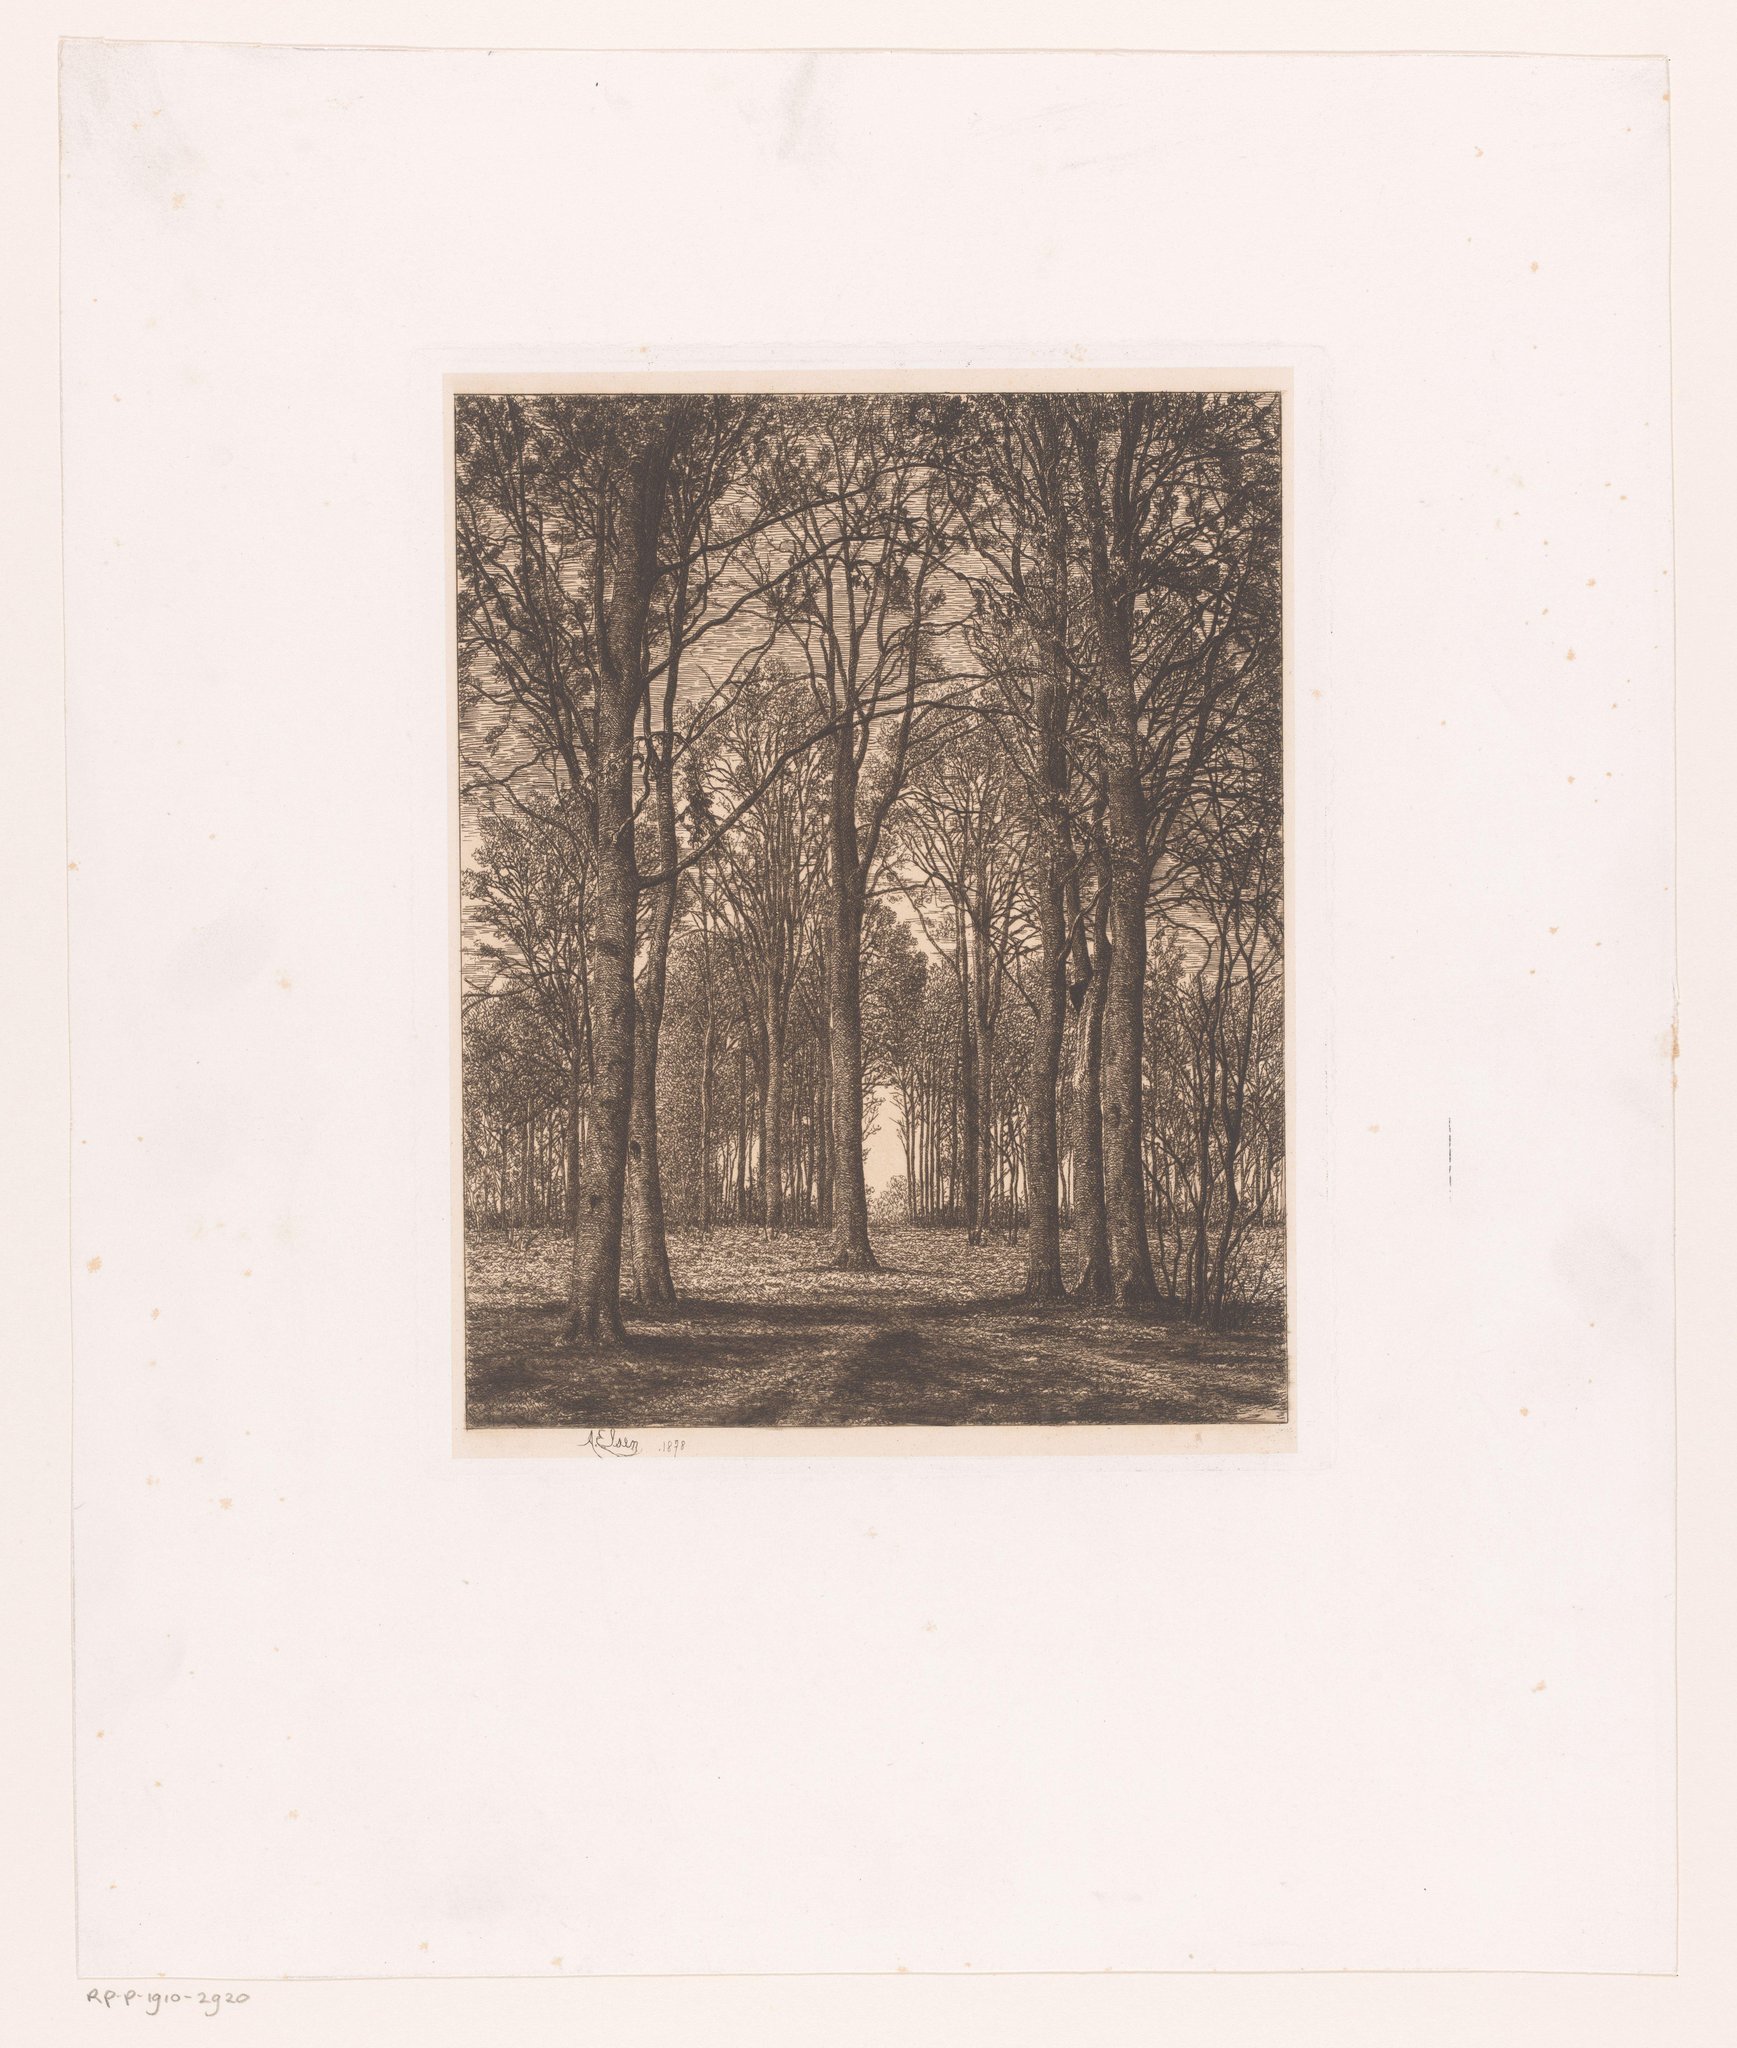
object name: print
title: Landschap met bomen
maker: alfred elsen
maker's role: painter, print maker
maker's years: 1850-1914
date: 1878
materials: paper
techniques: etching, intaglio, roulette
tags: trees, forest, wood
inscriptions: collector's mark: Lugt 2228